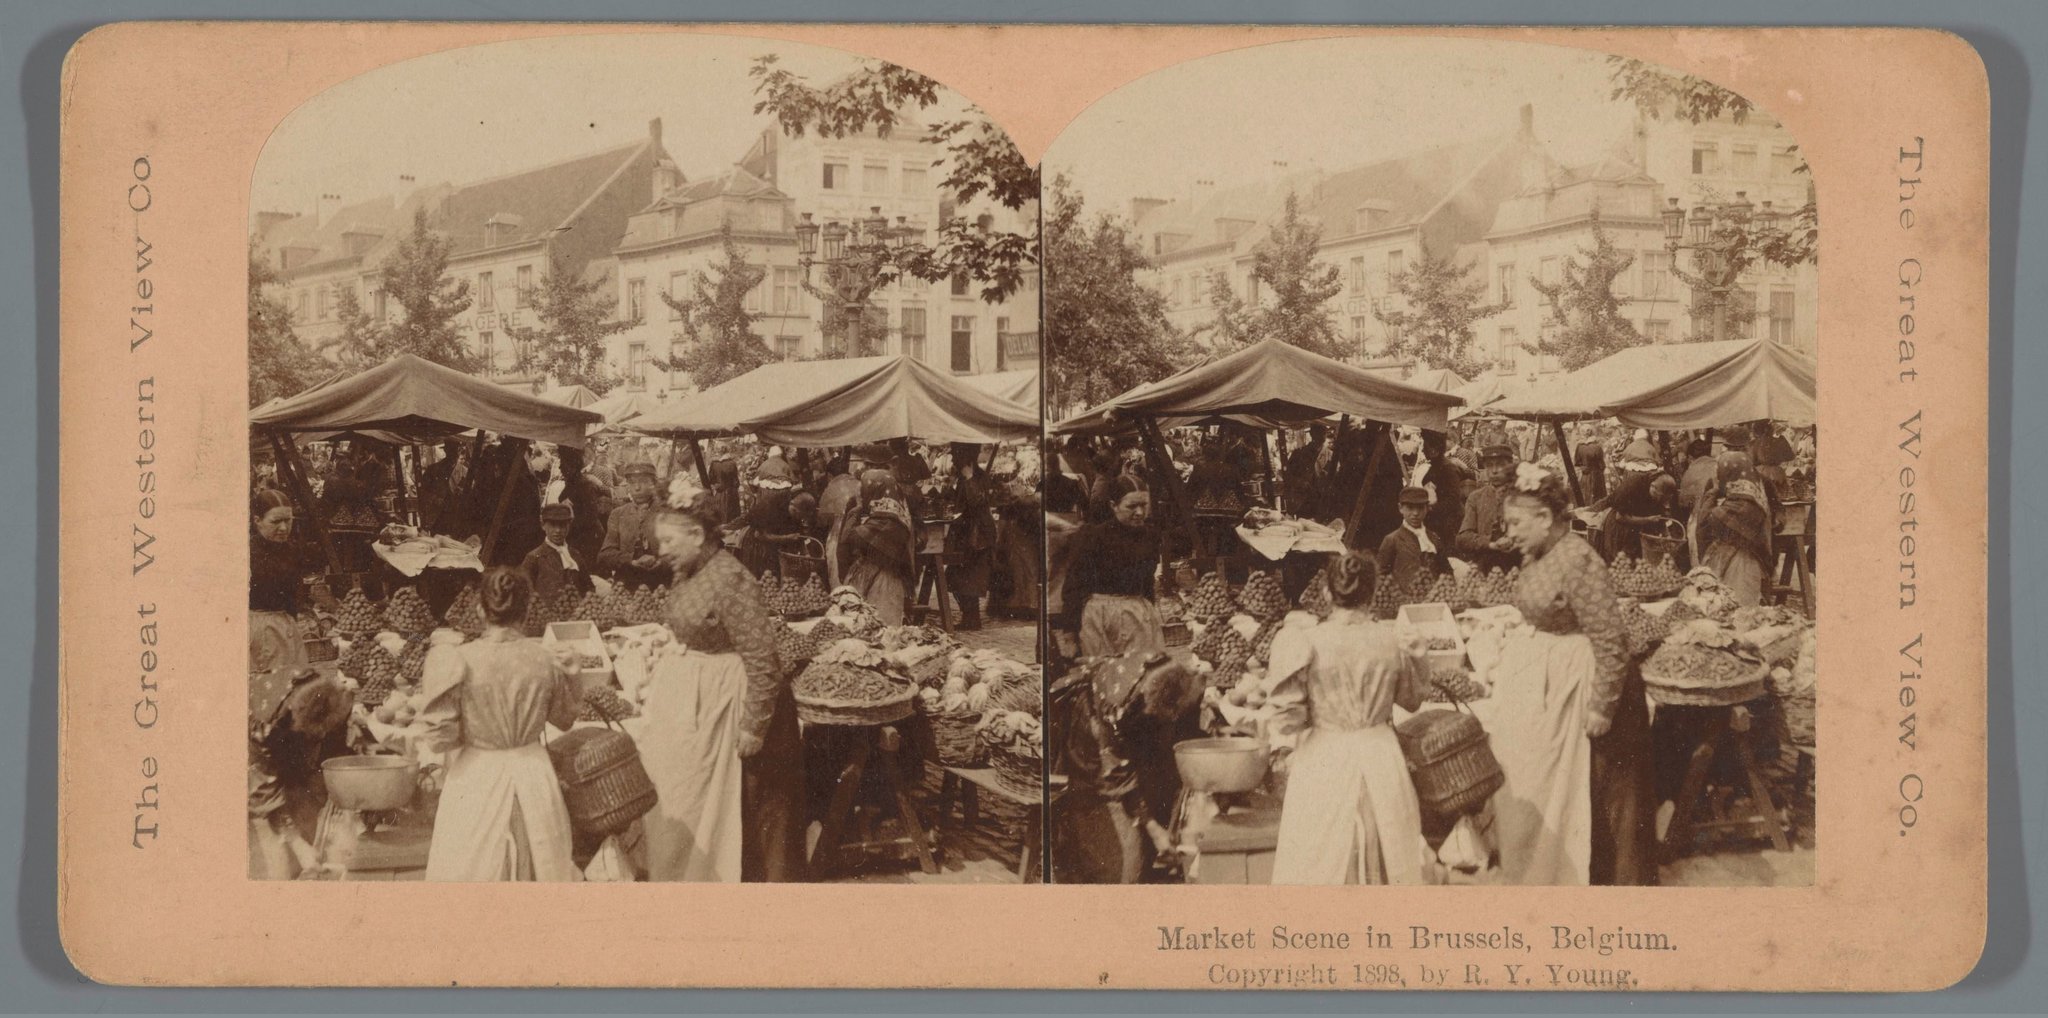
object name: stereograph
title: Markt in Brussel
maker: roddo y. young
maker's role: publisher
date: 1898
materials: cardboard, paper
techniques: albumen print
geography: brussels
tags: market, brussels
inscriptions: copyright notice: ‘Copyright 1898, by R. Y. Young.’